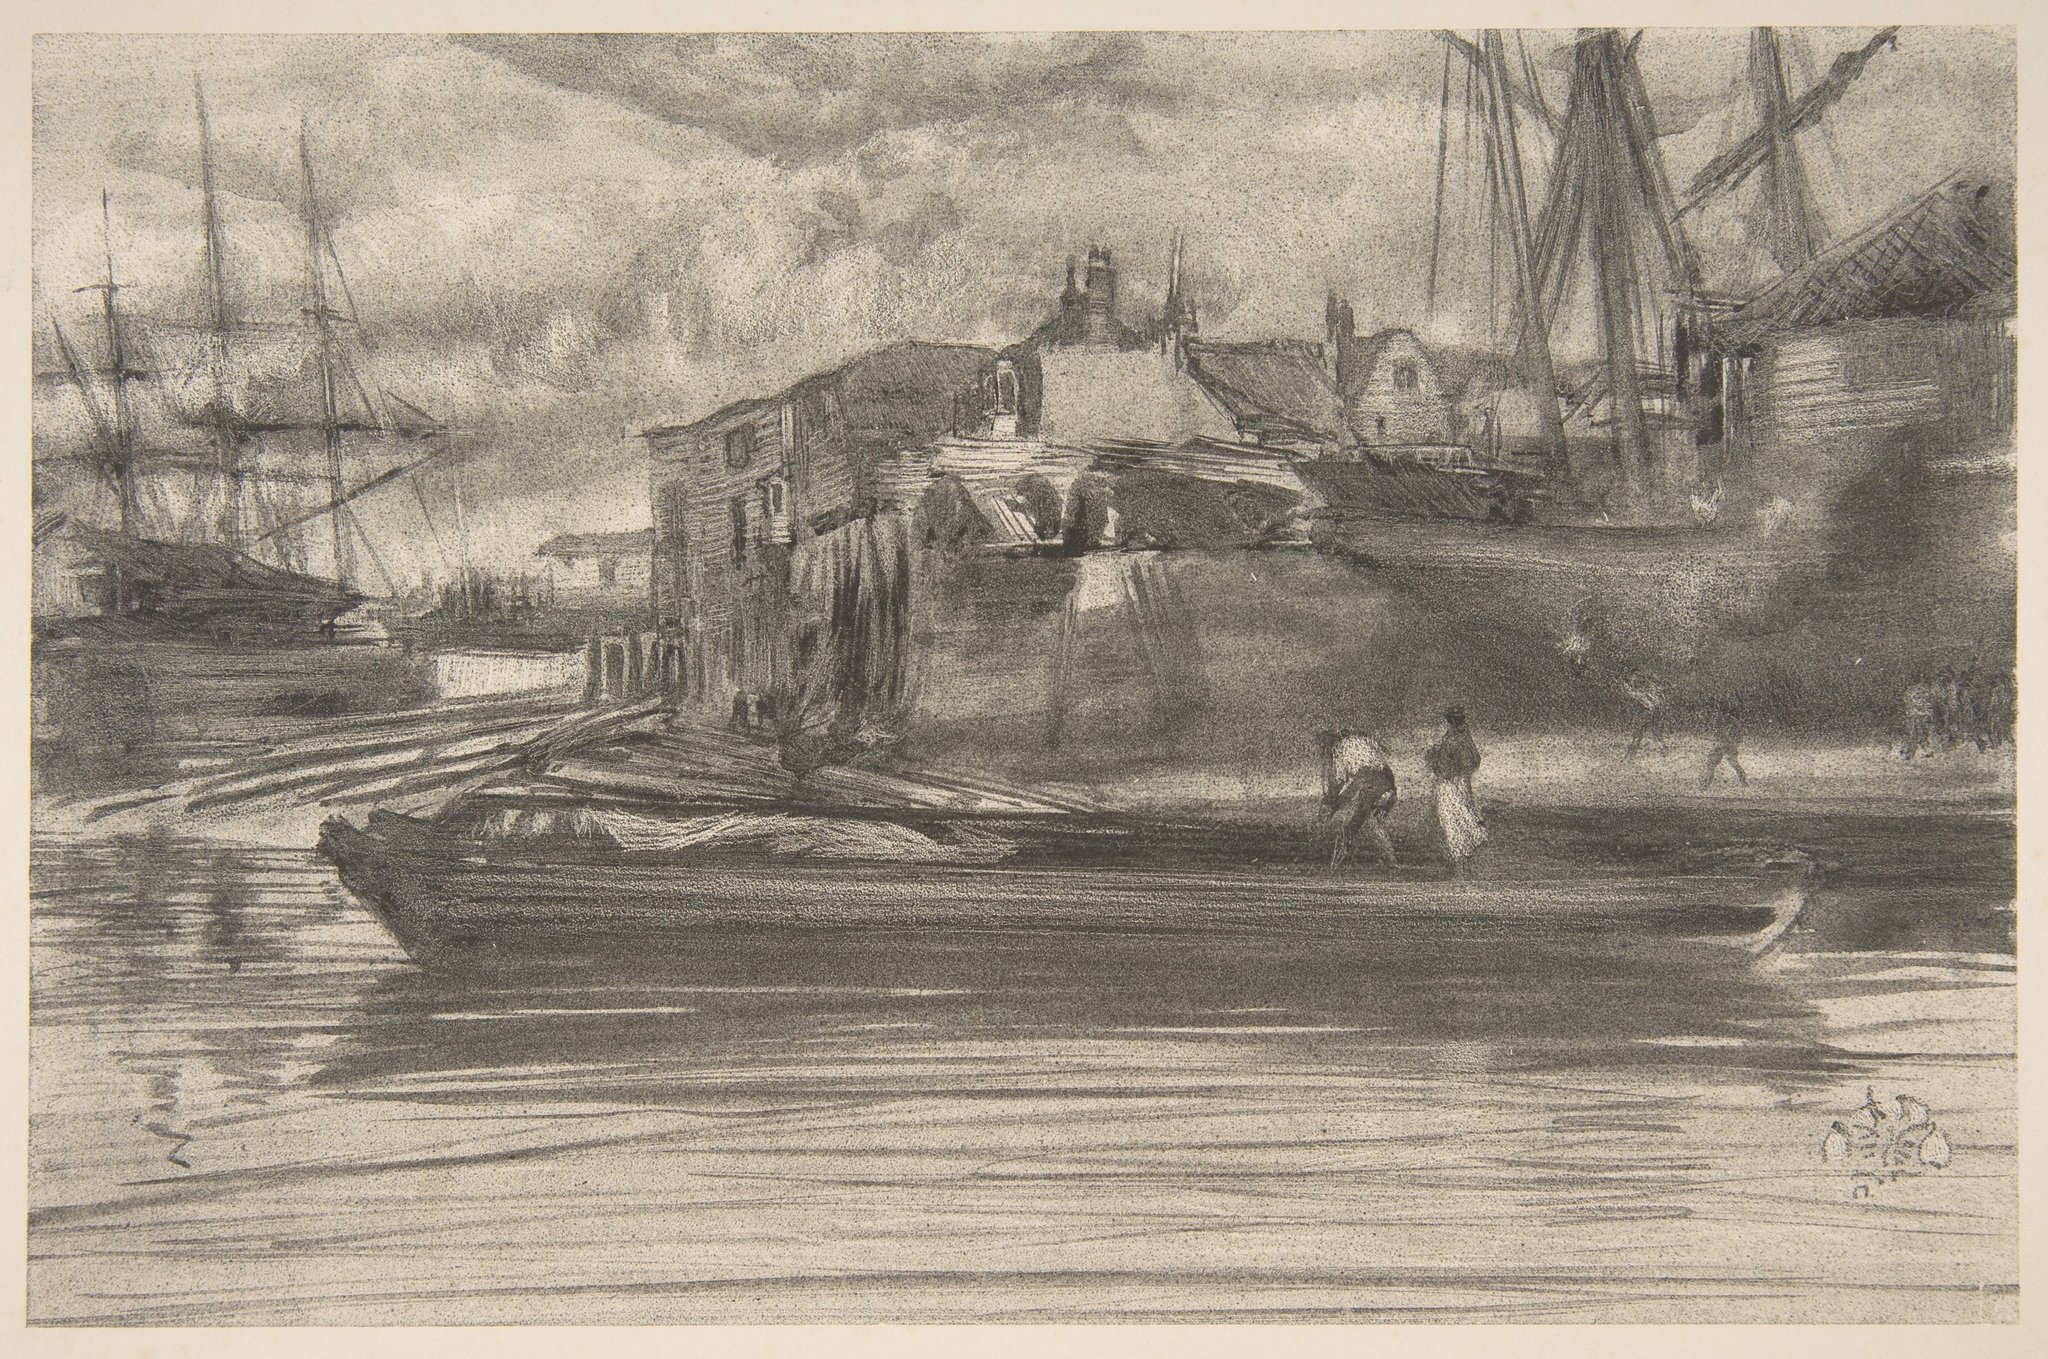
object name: print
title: Limehouse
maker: james mcneill whistler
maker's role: artist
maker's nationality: american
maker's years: 1834-1903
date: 1878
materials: ink, paper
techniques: printing, scraping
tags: houses,boats,ships